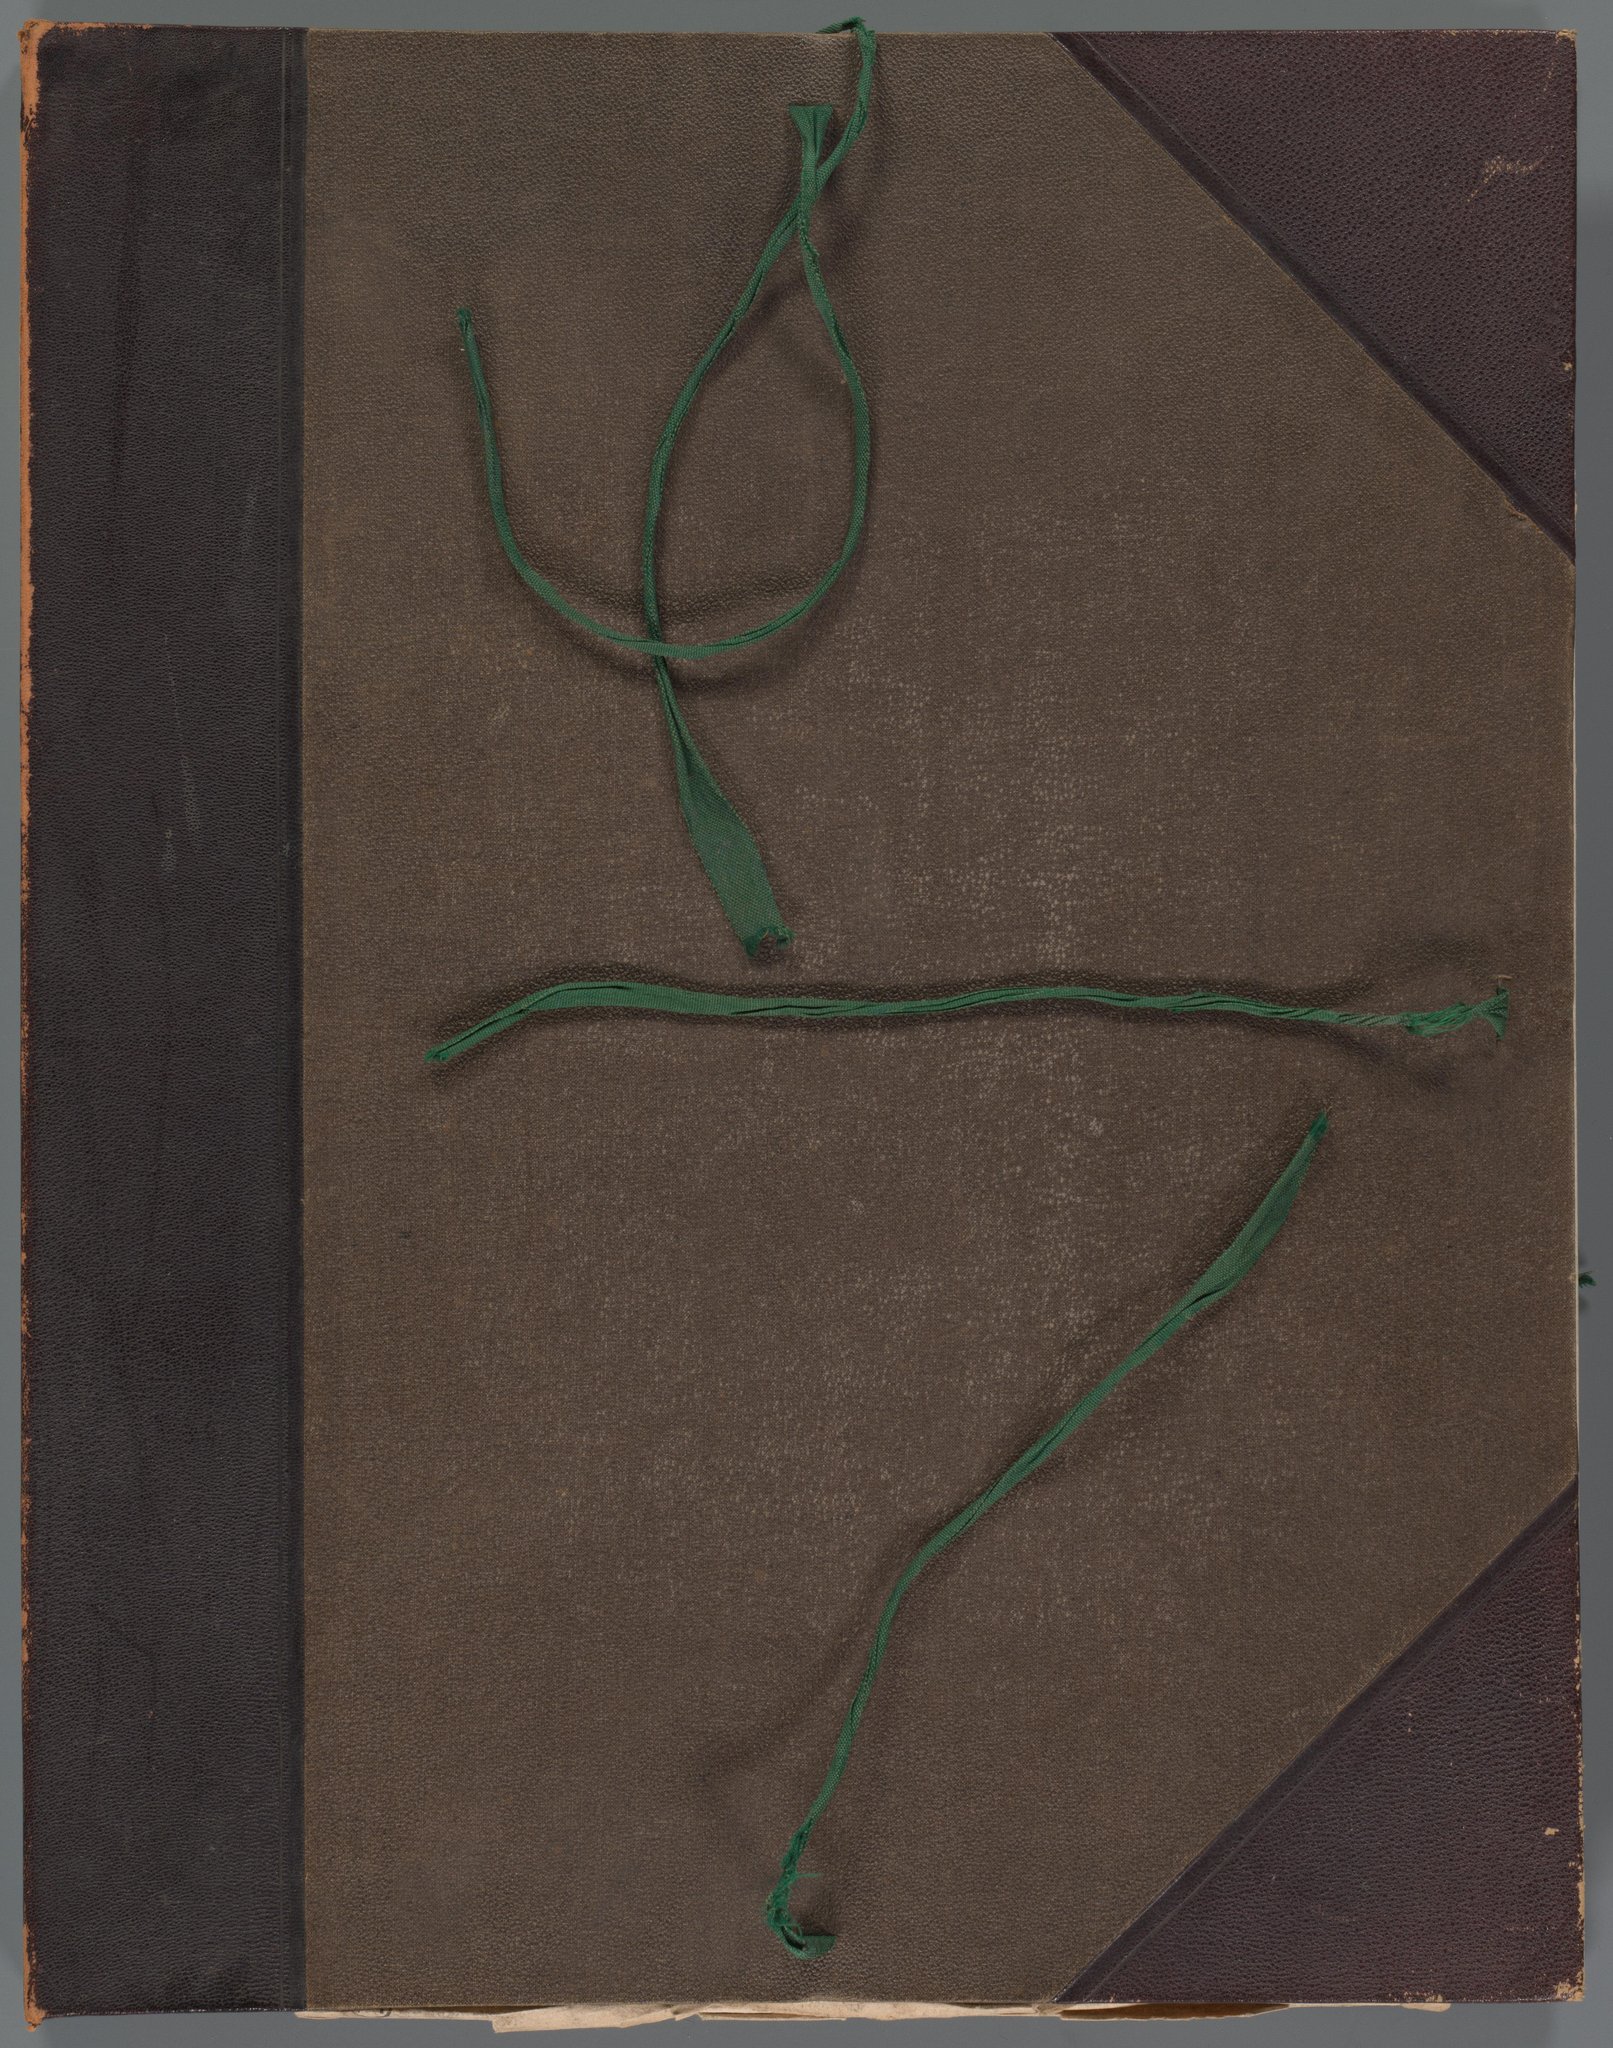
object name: wrapper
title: Teekeningen Dijsselhof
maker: Anonymous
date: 1900-1924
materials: cardboard, linen, paper, ribbon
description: Met voorin de omslag een index van de tekeningen met goudkarpers. Er zitten enkele hiaten in de nummering van de tekeningen.